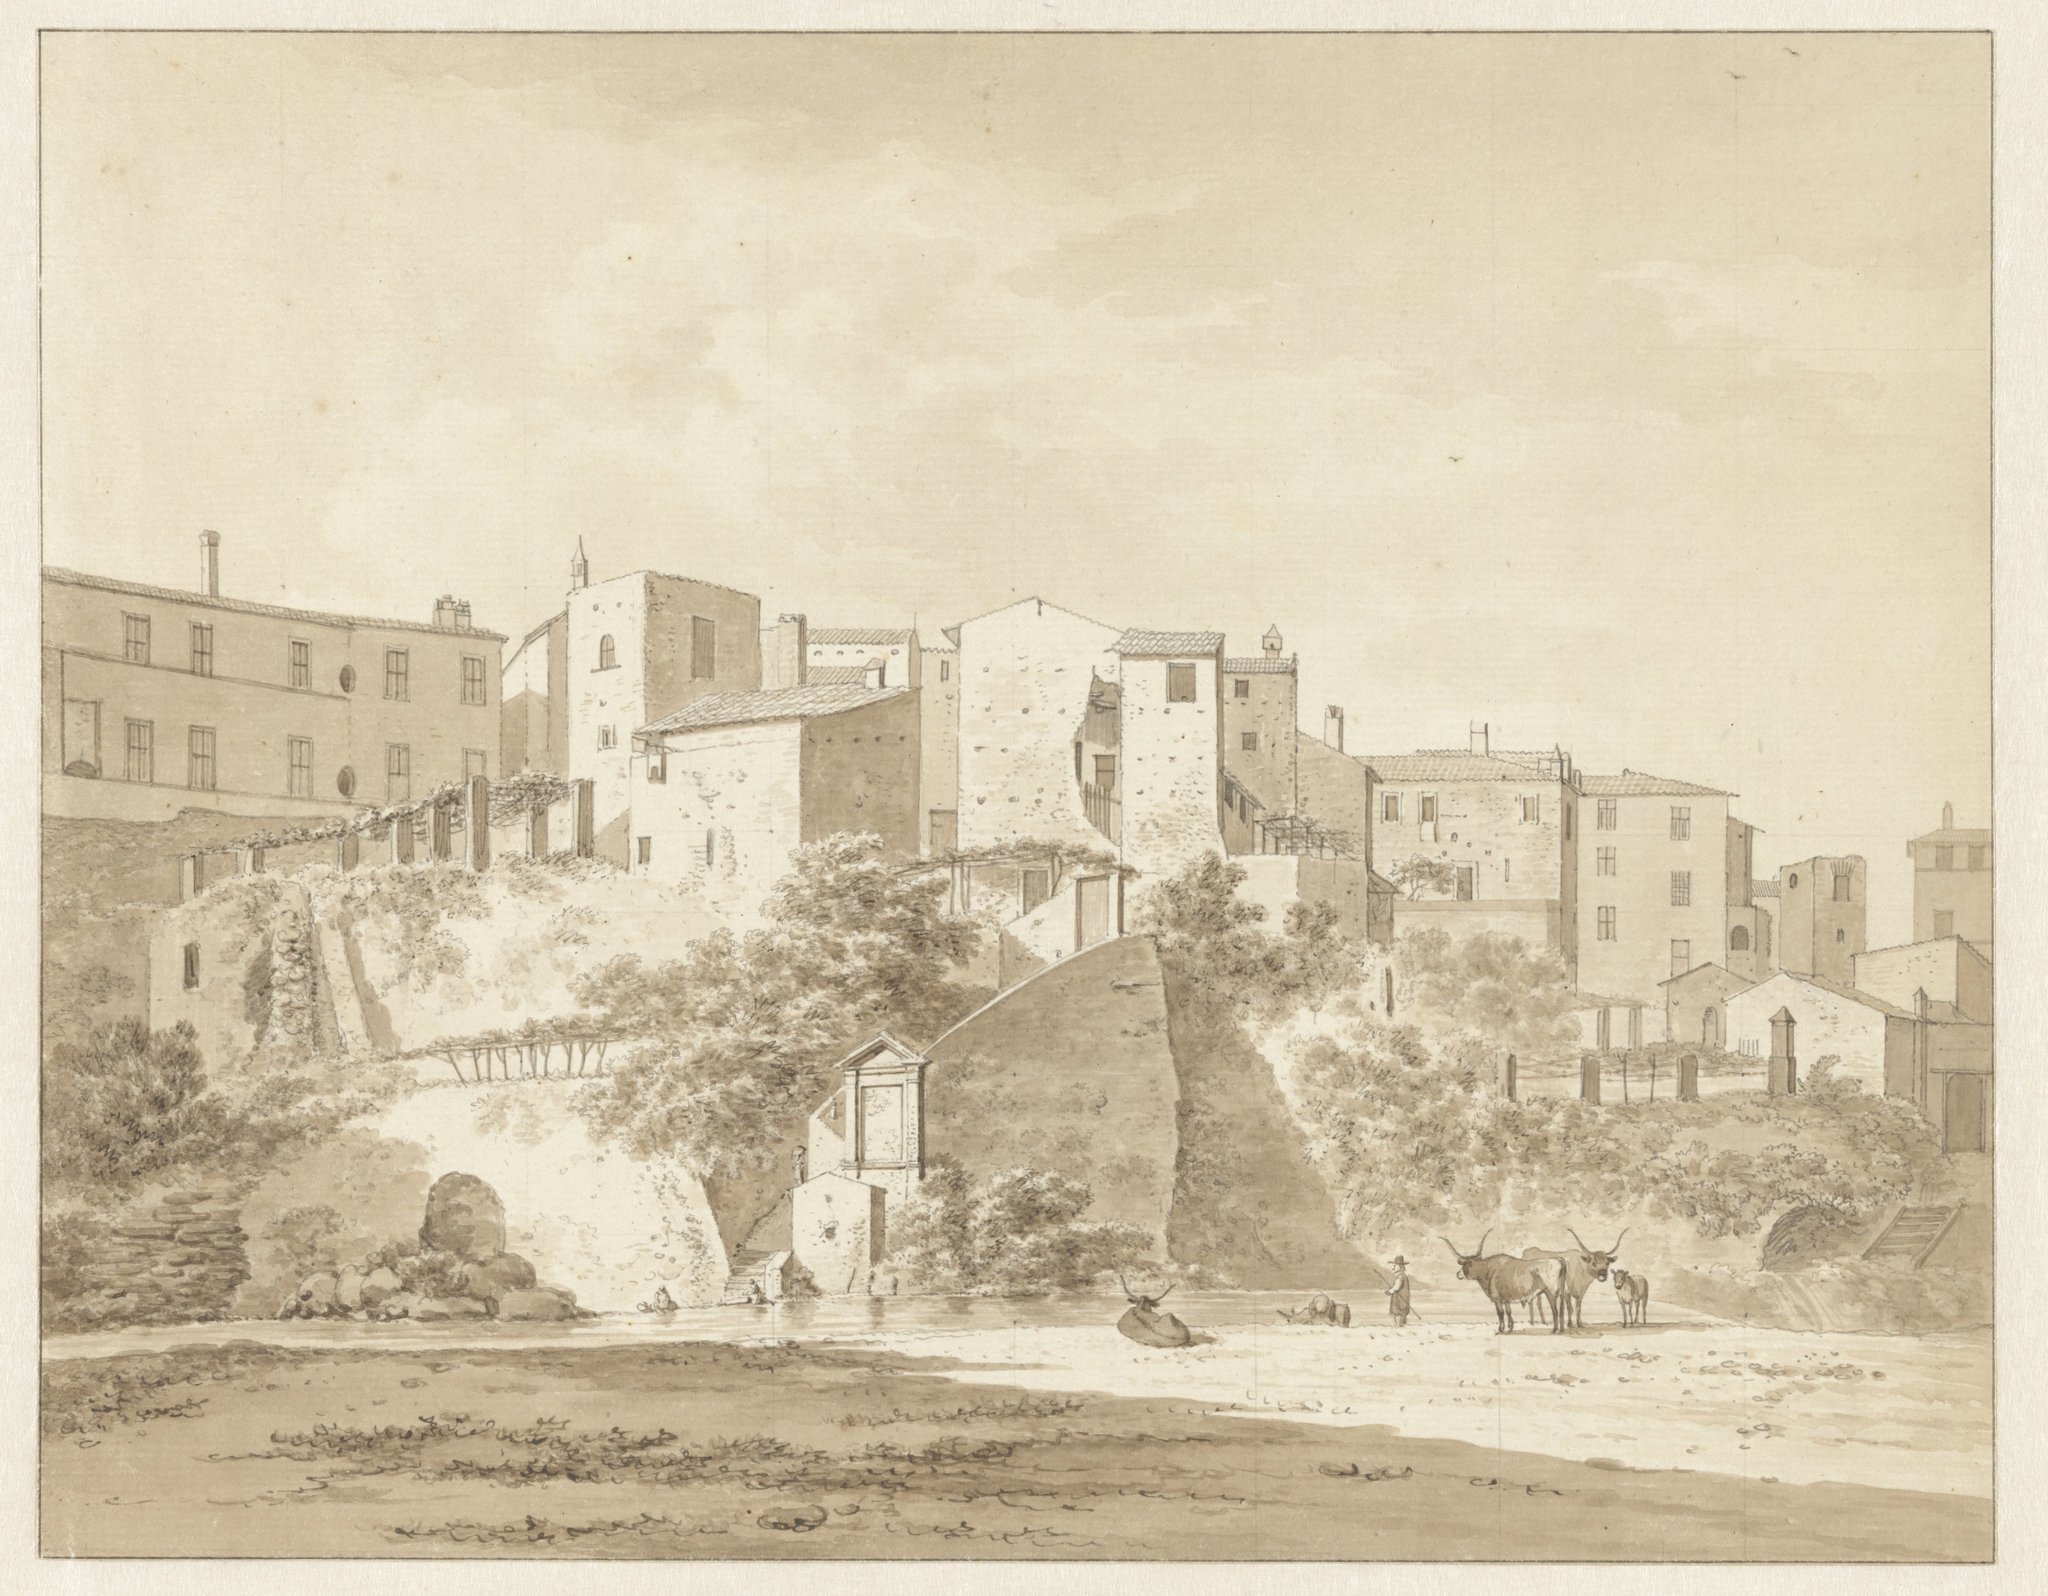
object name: drawing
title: Gezicht op de watervallen van Tivoli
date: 1761-1817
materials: graphite, ink, paper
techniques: brush, pen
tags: tivoli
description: Tekening uit een groep tekeningen van landschappen en stadsgezichten in Italië (Rome, Tivoli, Civita Castellana en Pozzuoli).